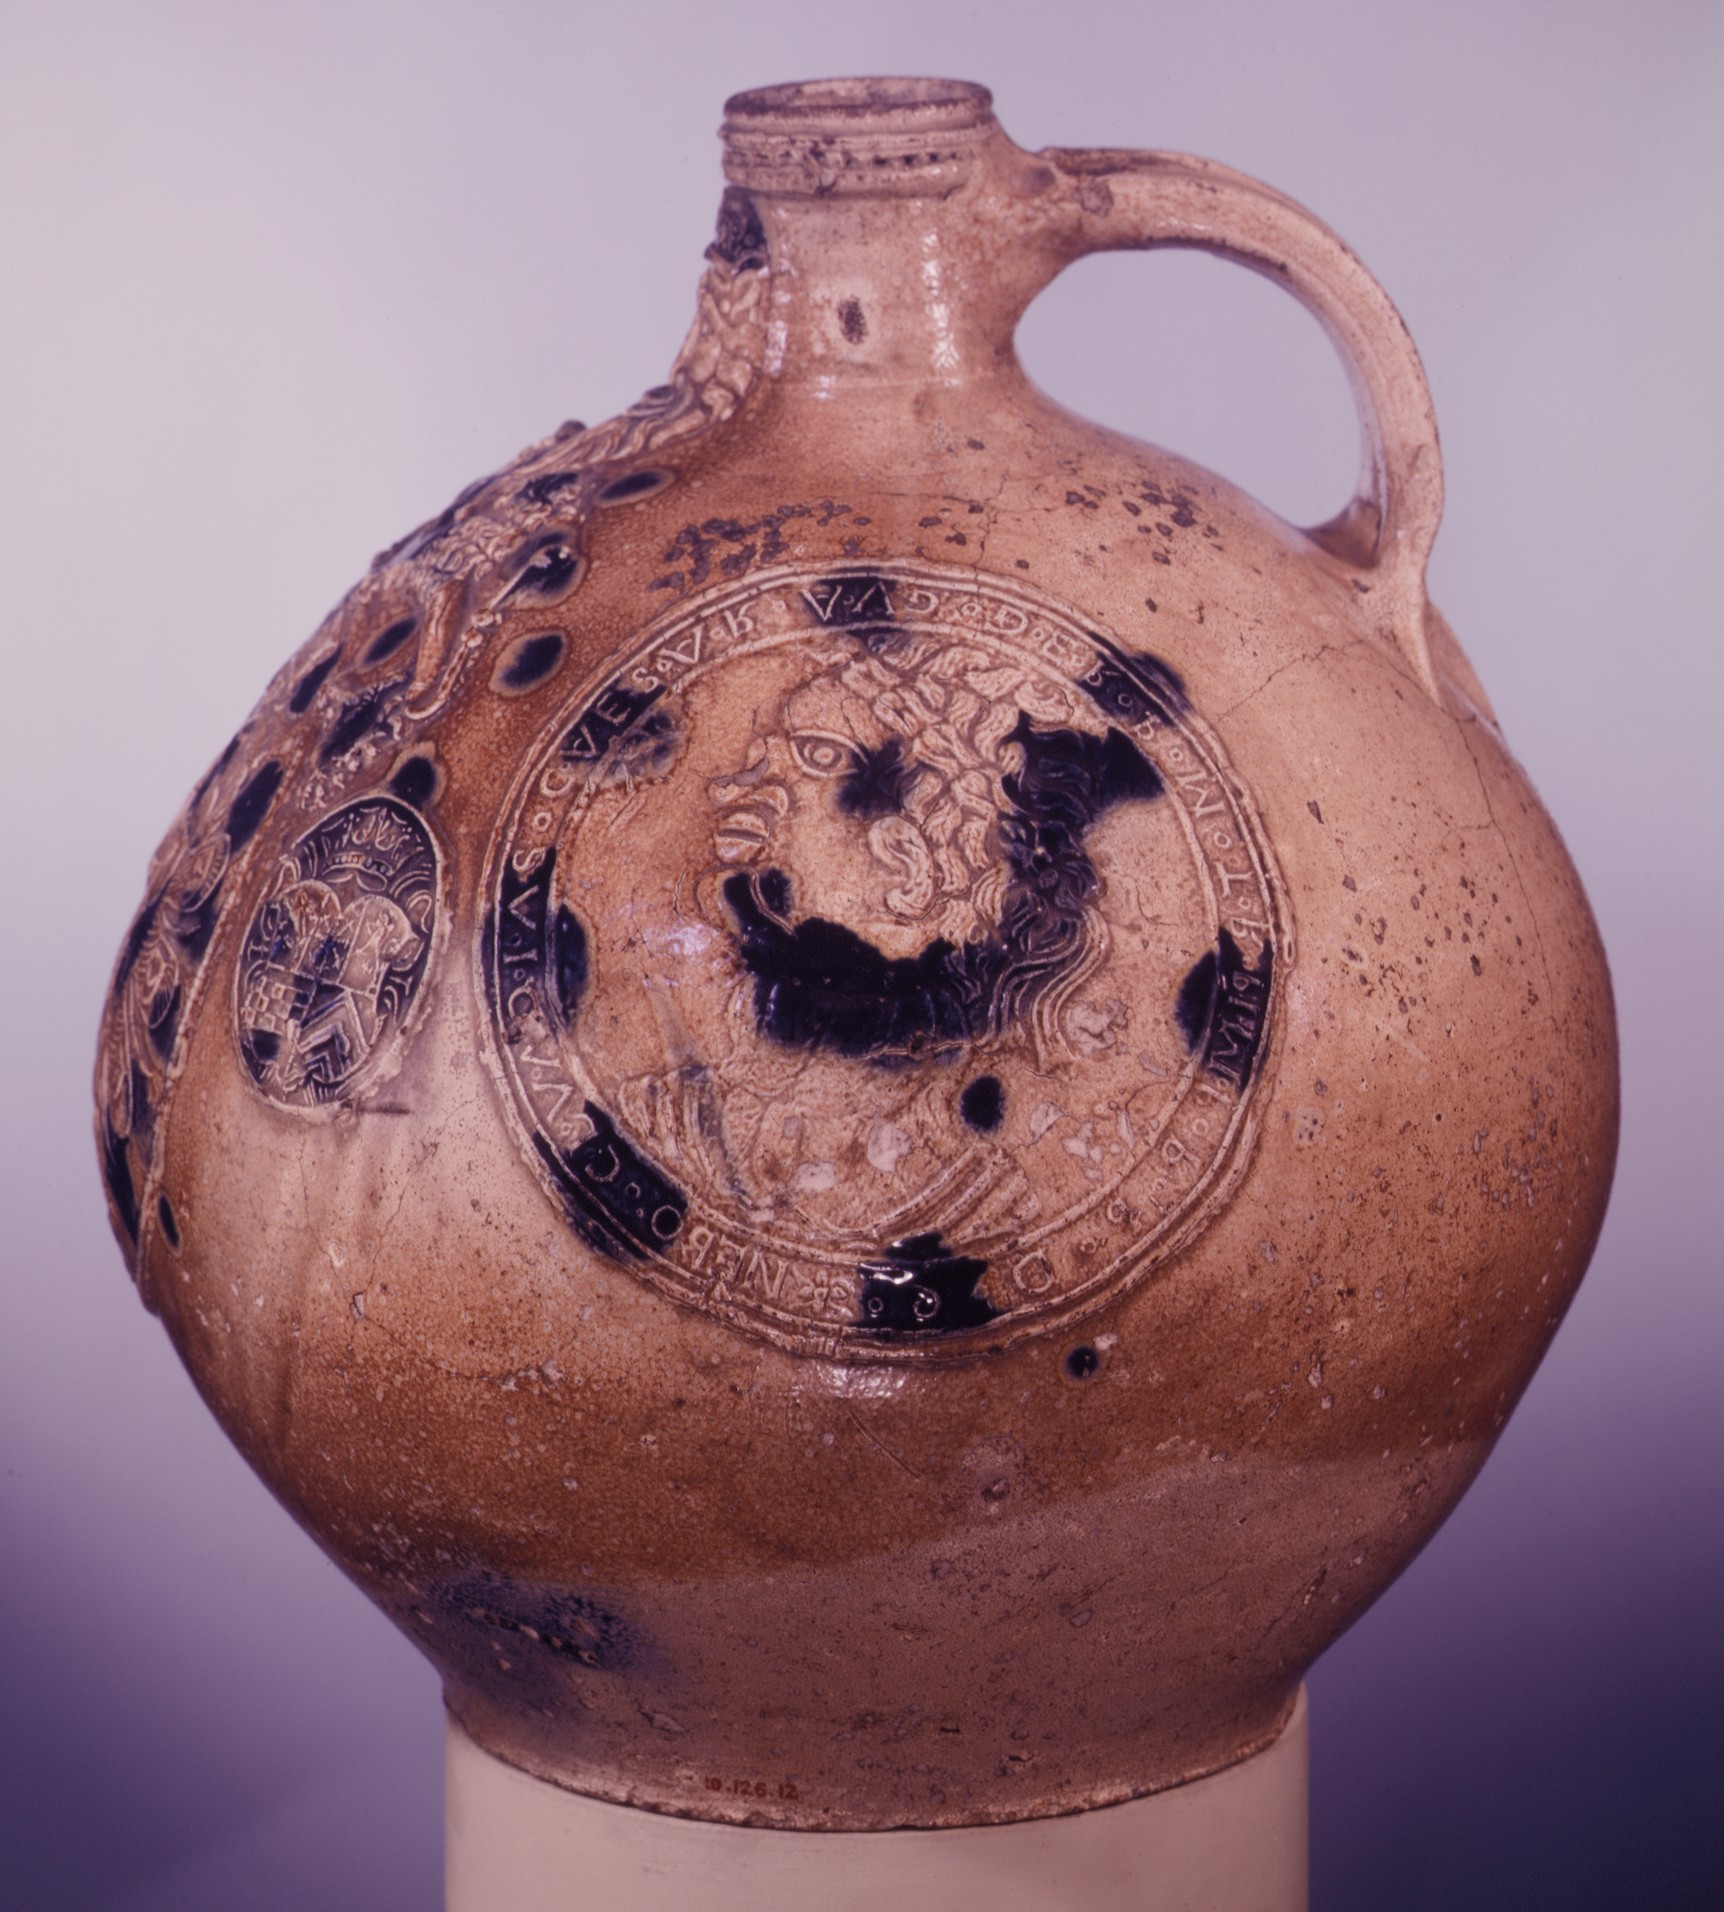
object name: bottle jug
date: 1595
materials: stoneware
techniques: salt glaze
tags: profiles